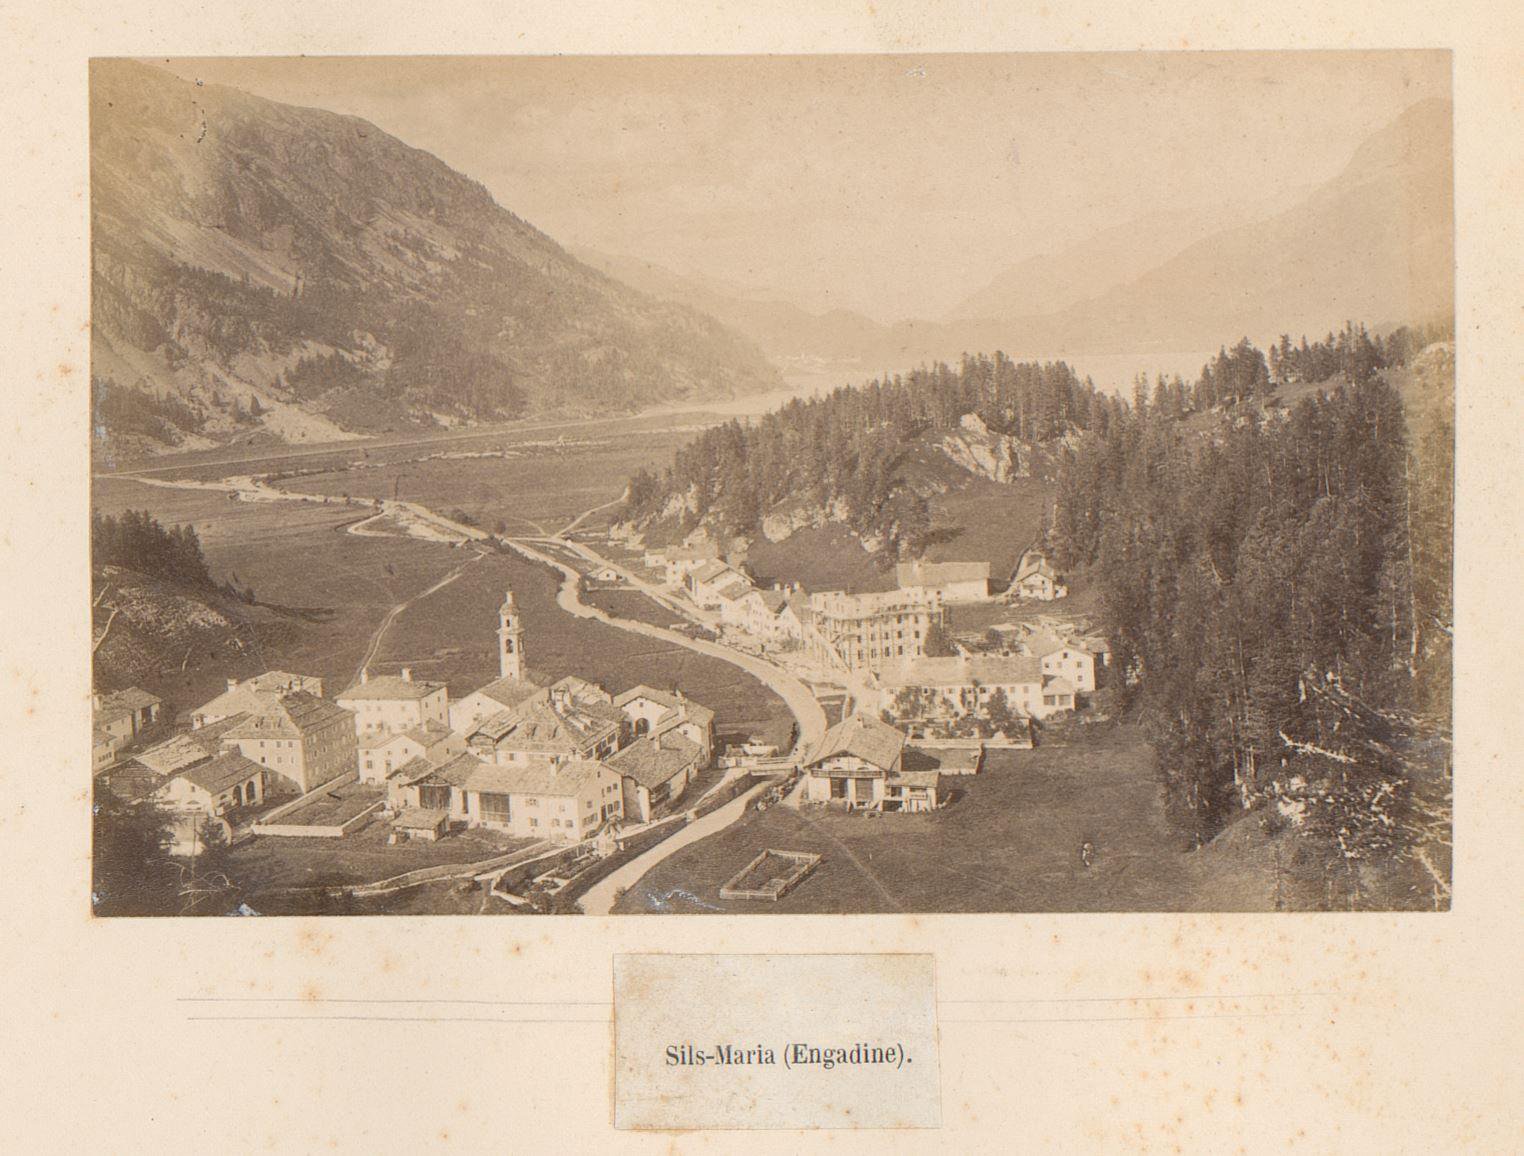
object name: photograph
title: Gezicht op Sils im Engadin, Zwitserland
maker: Anonymous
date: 1860-1890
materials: paper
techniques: albumen print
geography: sils maria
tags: prospect of village, silhouette of village, dale, valley